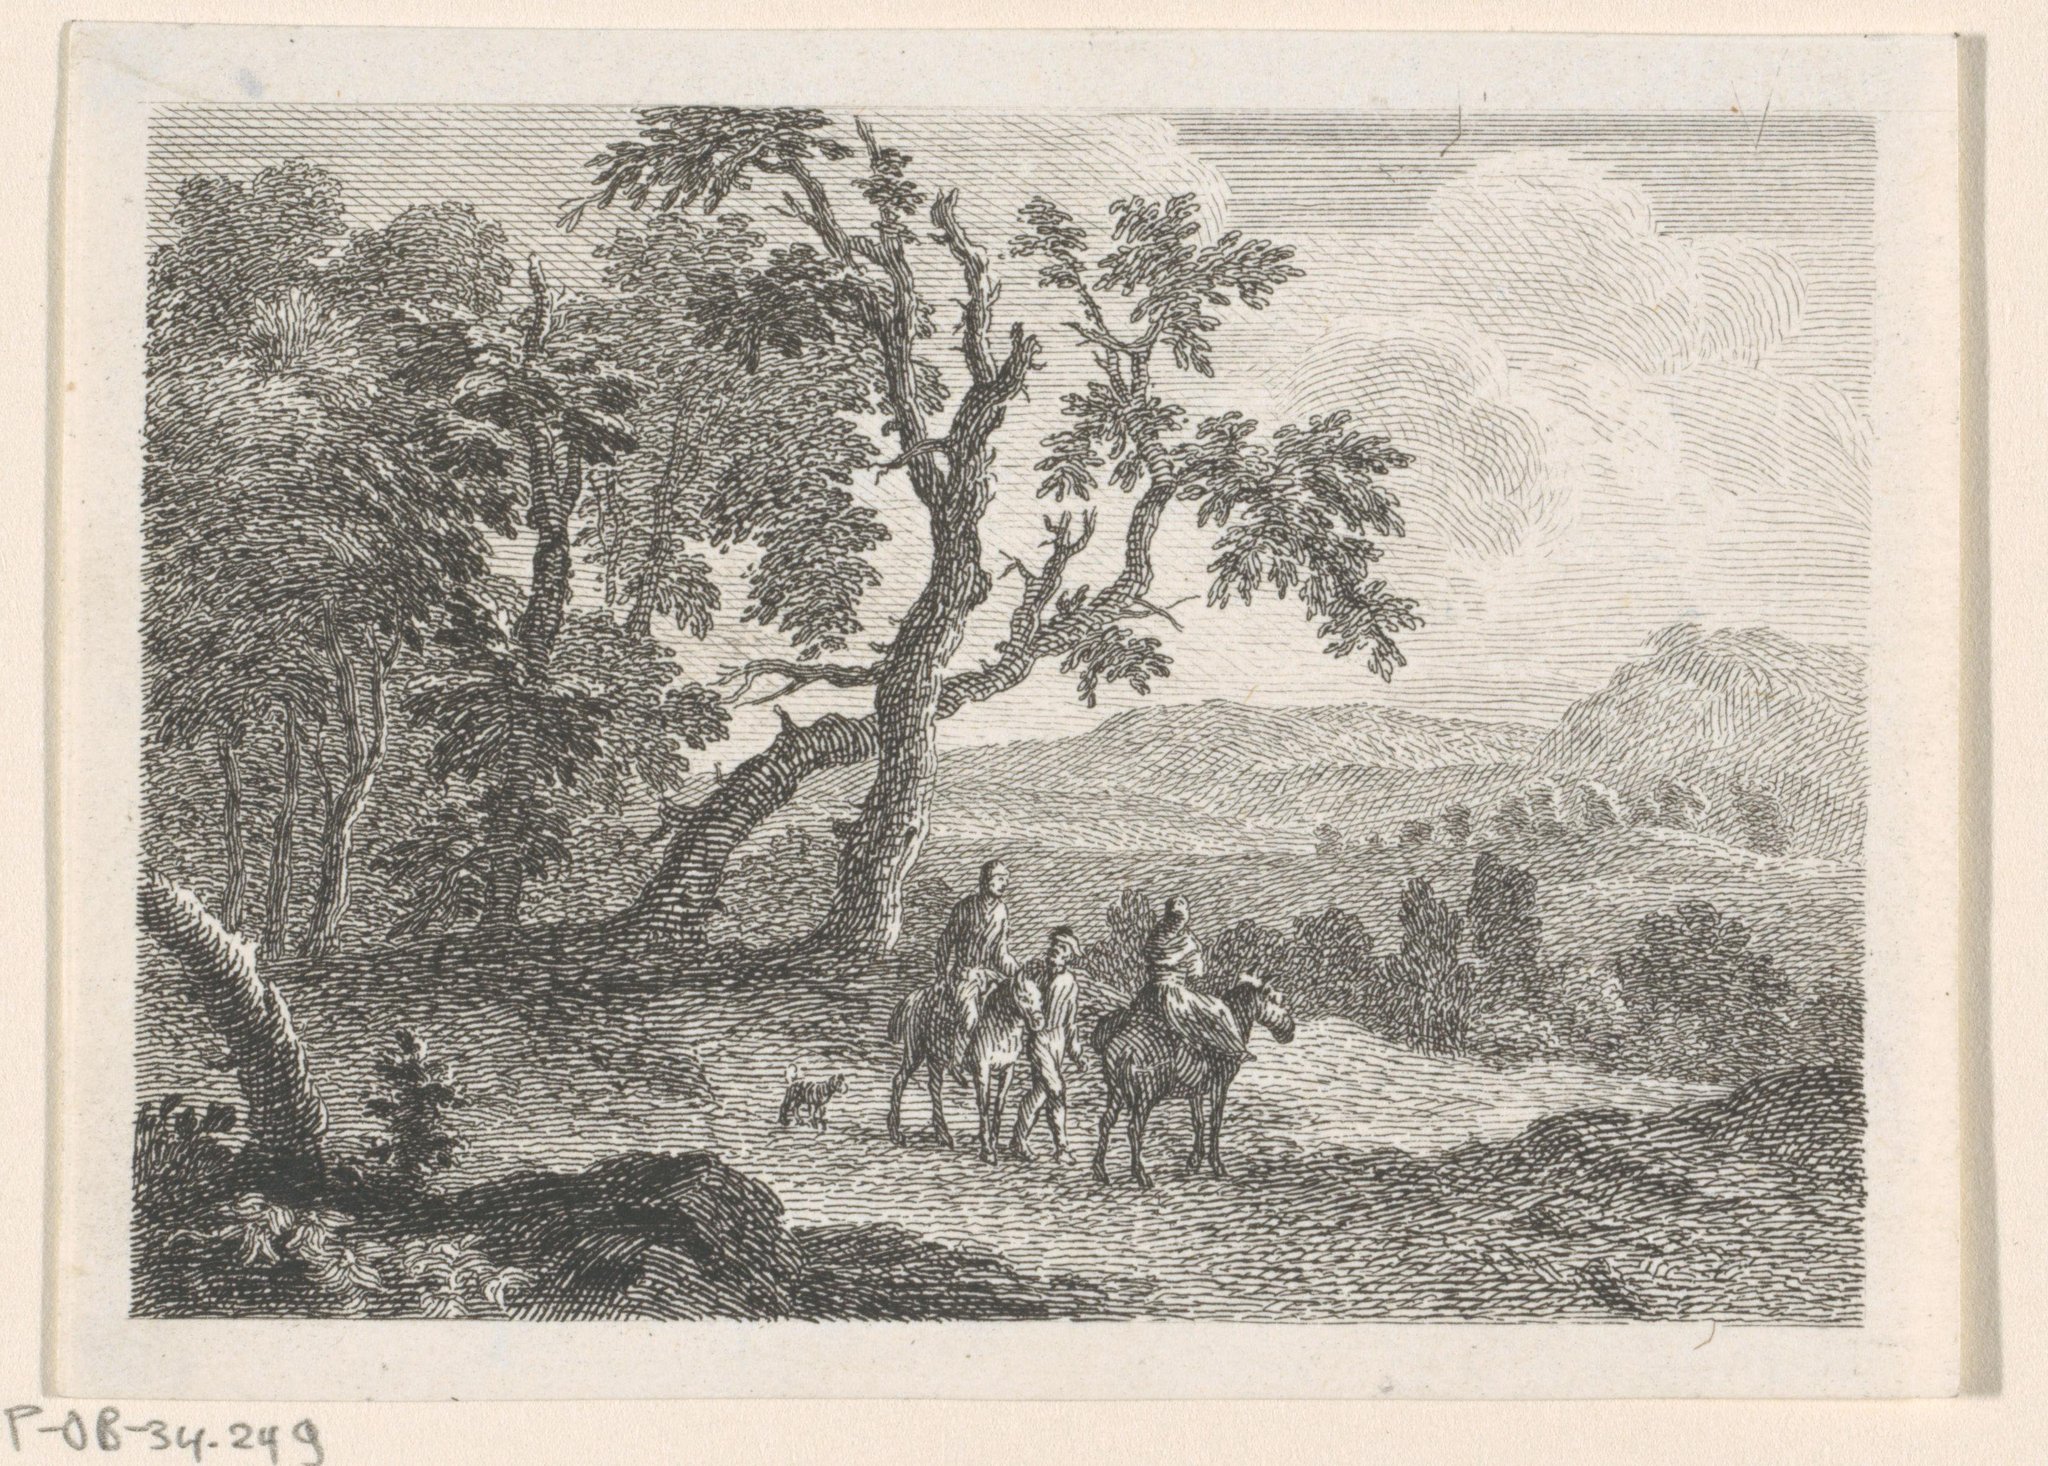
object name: print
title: Landschap met figuren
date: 1739-1780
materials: paper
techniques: engraving, etching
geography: venice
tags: riding a horse, ass, or mule; rider, horseman, pack-animal, landscapes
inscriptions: collector's mark: Lugt 240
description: Landschap met twee figuren te paard, een lopende figuur en een hond.